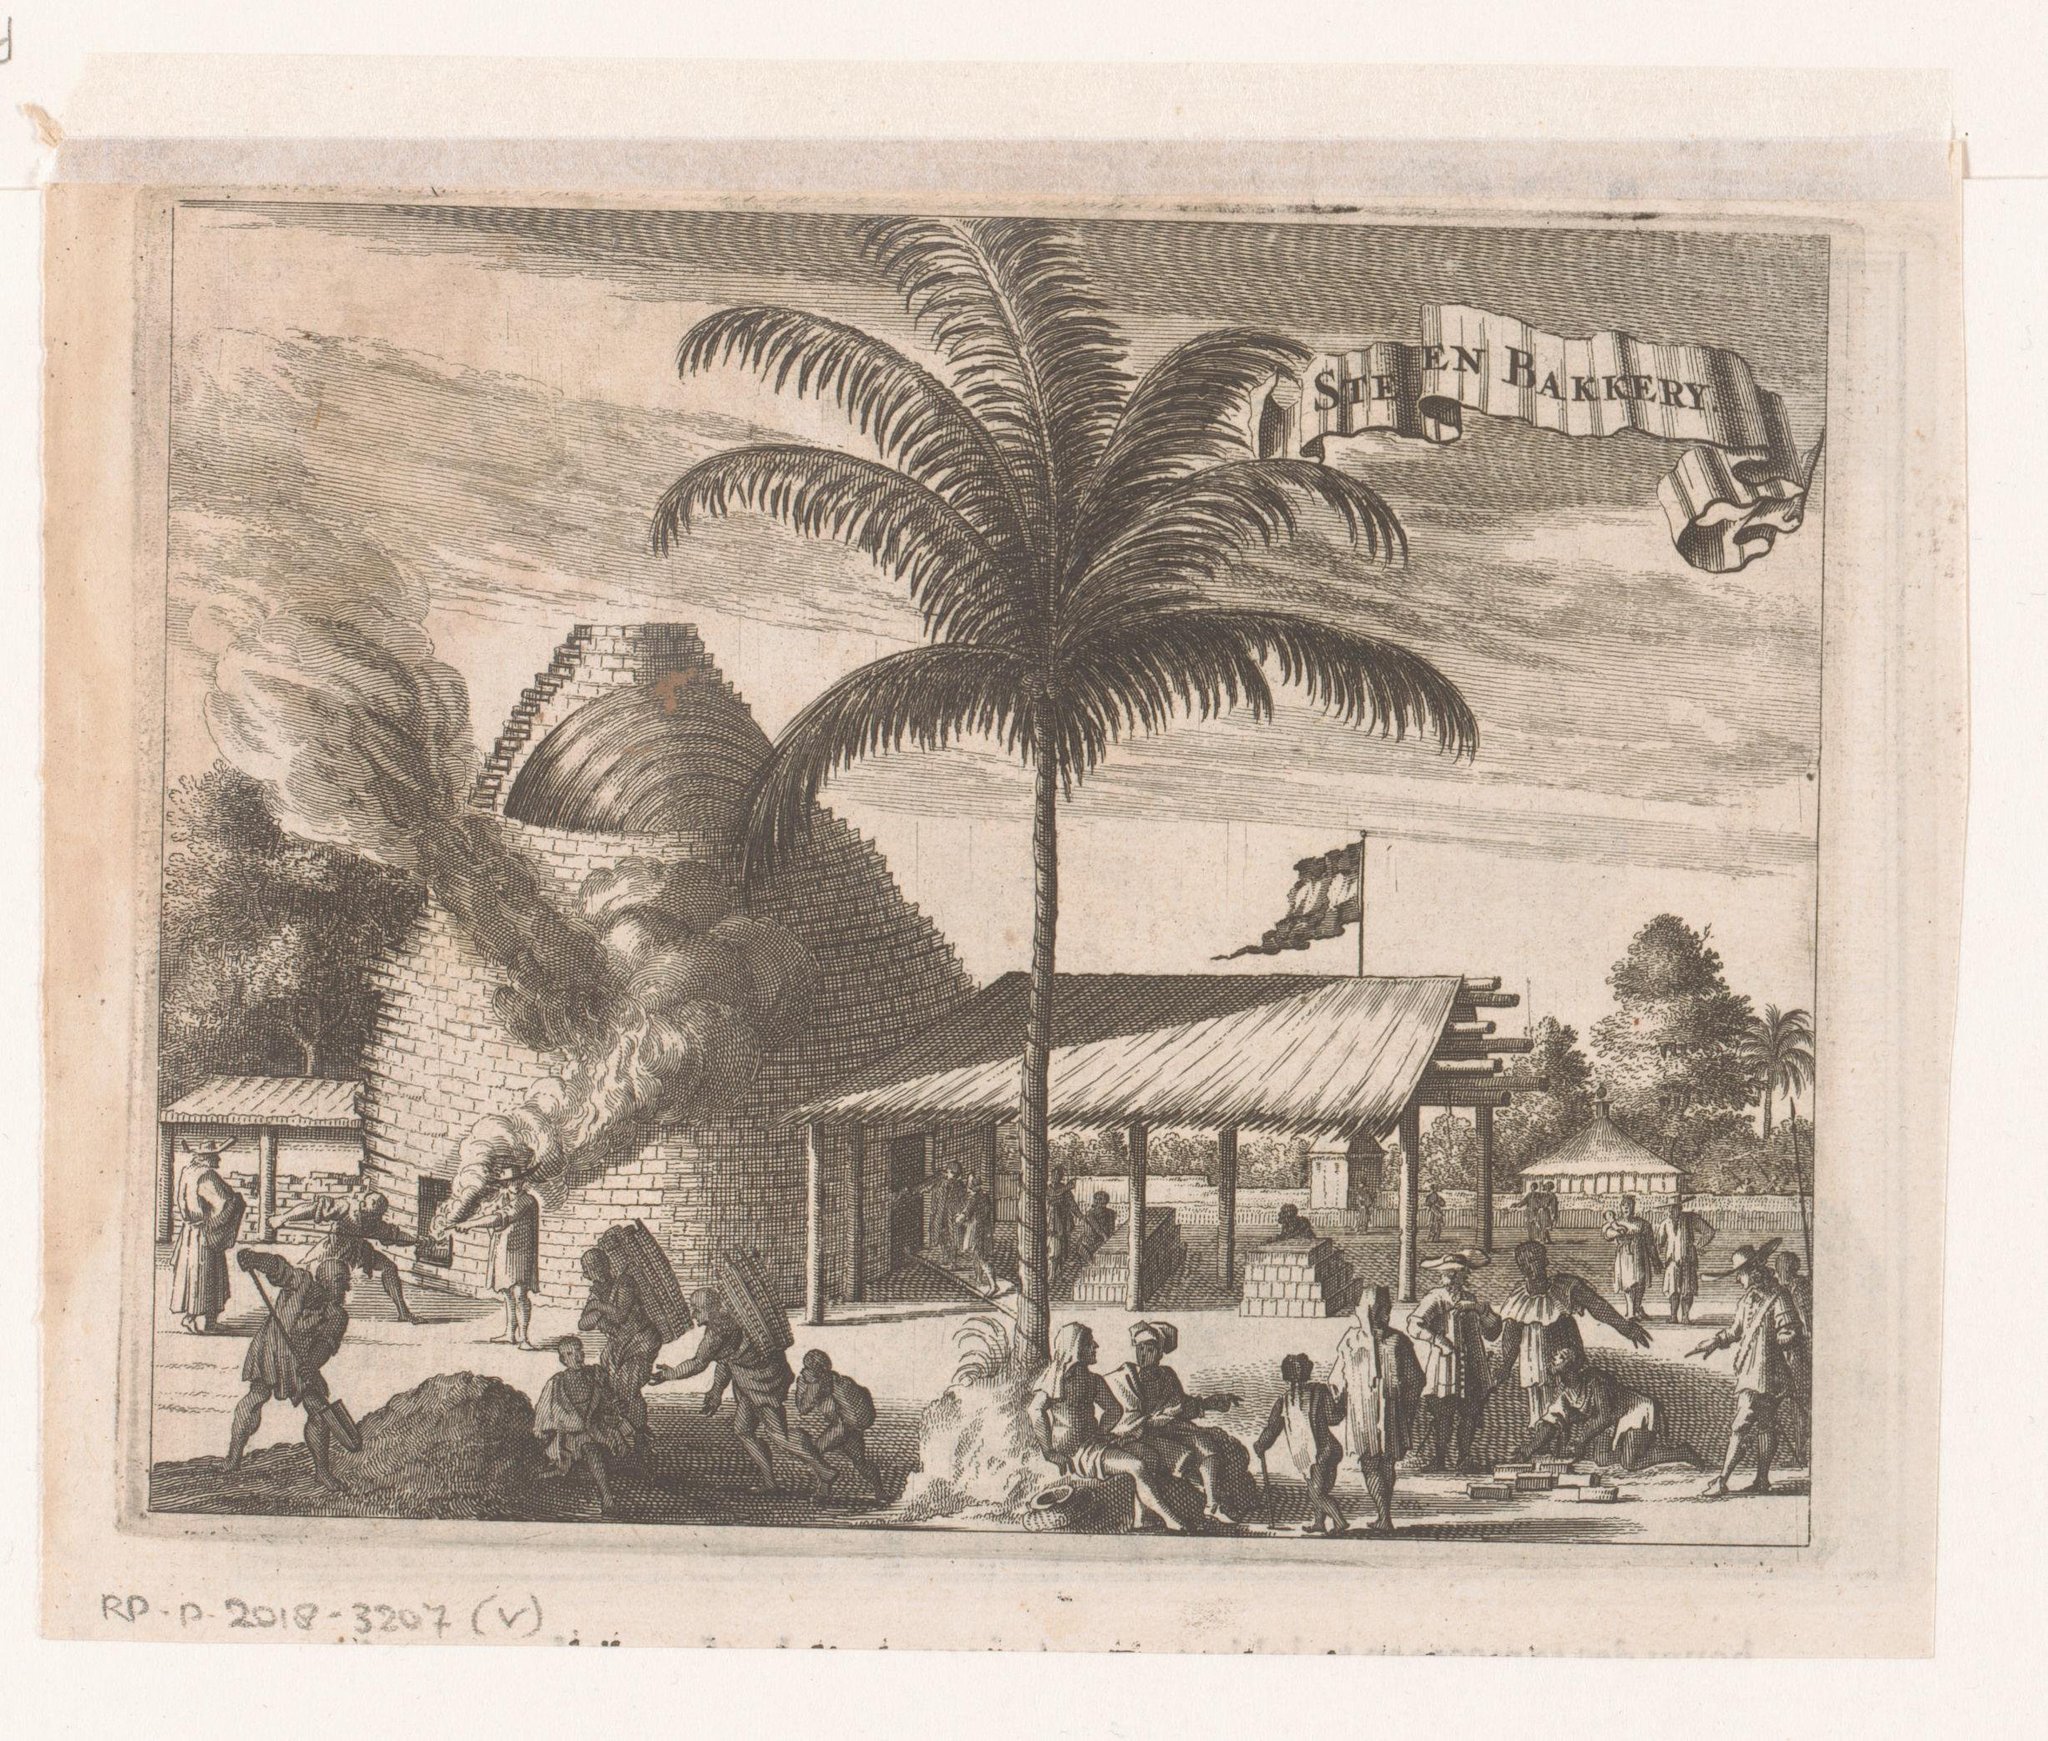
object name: print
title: Steenbakkerij buiten Batavia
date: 1682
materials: paper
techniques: engraving, etching, letterpress printing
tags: brick works, batavia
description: Prent uit: Nieuhof, Joan. Joan Nieuhofs zee en lant-reize, door verscheide Gewesten van Oostindien (...). Amsterdam: Jacob van Meurs, 1682, p. 211.